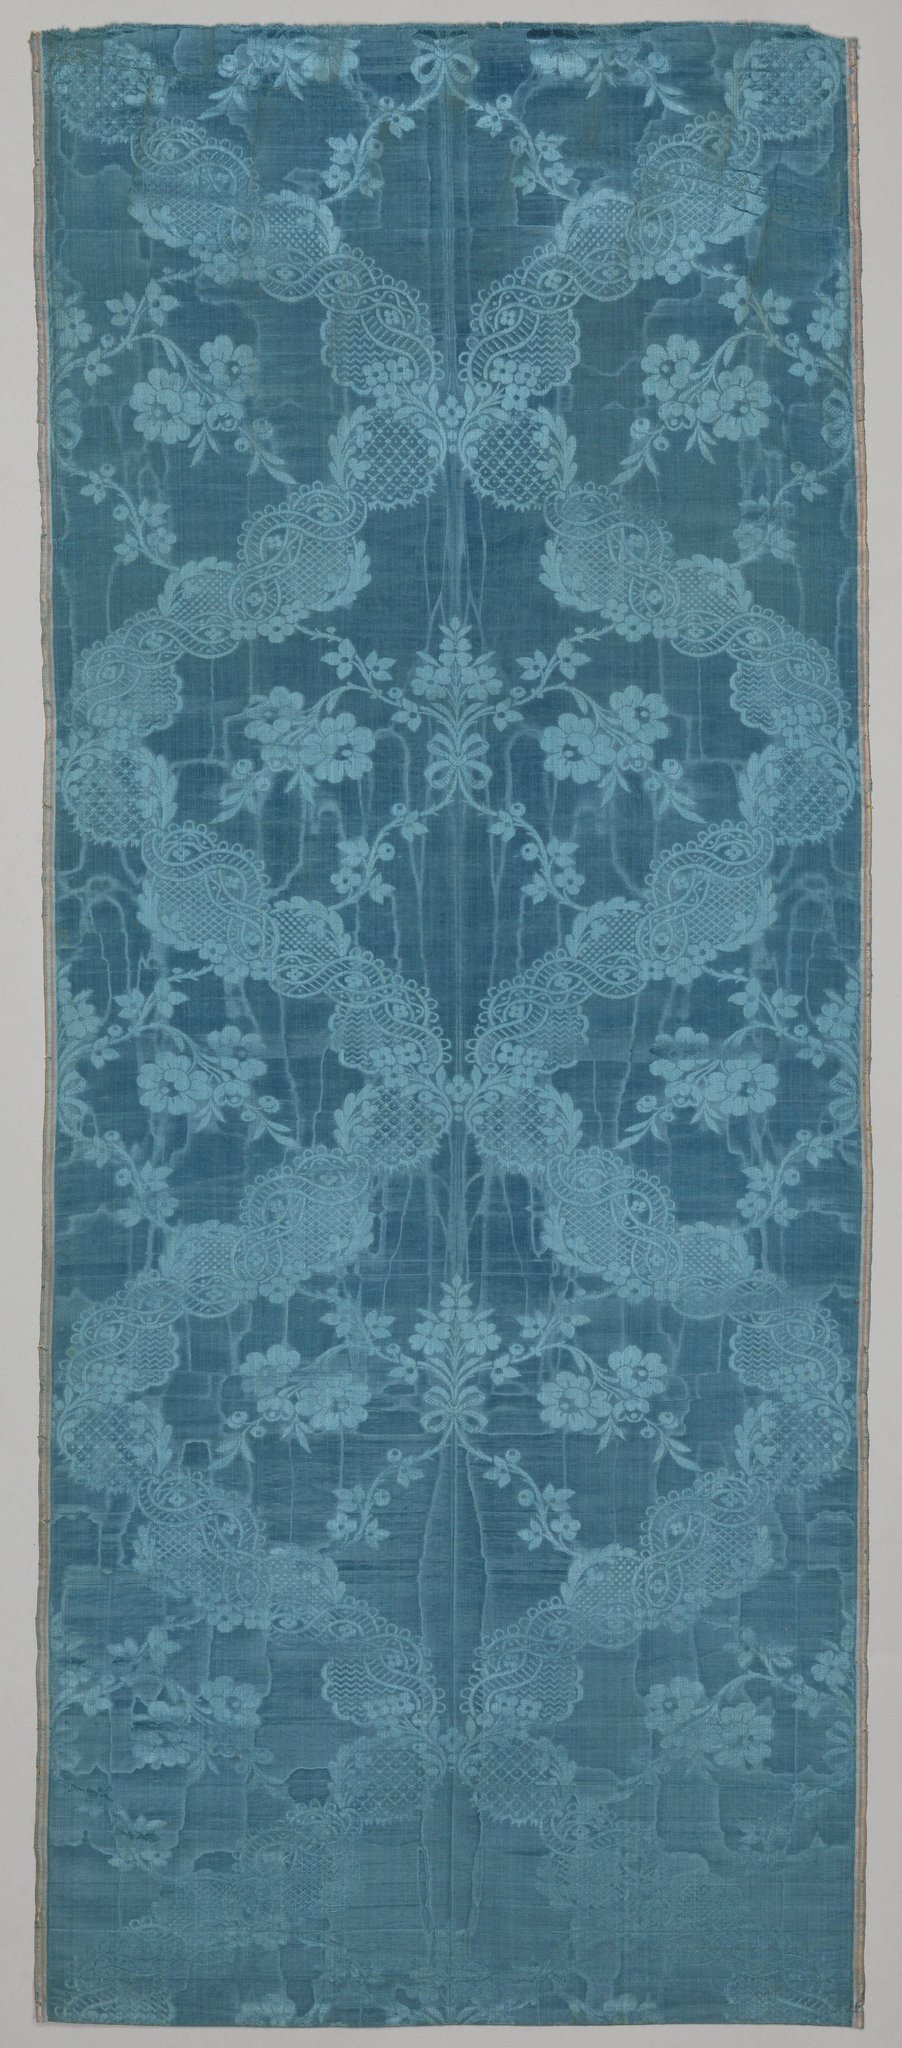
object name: zijdedamast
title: Fragment zijdedamast, blauw, met patroon van bloemen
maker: Anonymous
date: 1760-1770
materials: silk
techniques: damask, moire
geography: france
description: Fragmenten zijdedamast, blauw, met patroon van bloemen. In een brief uit 1976 van de heer C. Burgers, gevonden in de losse doucmentatie wordt over vier fragmenten gesproken.